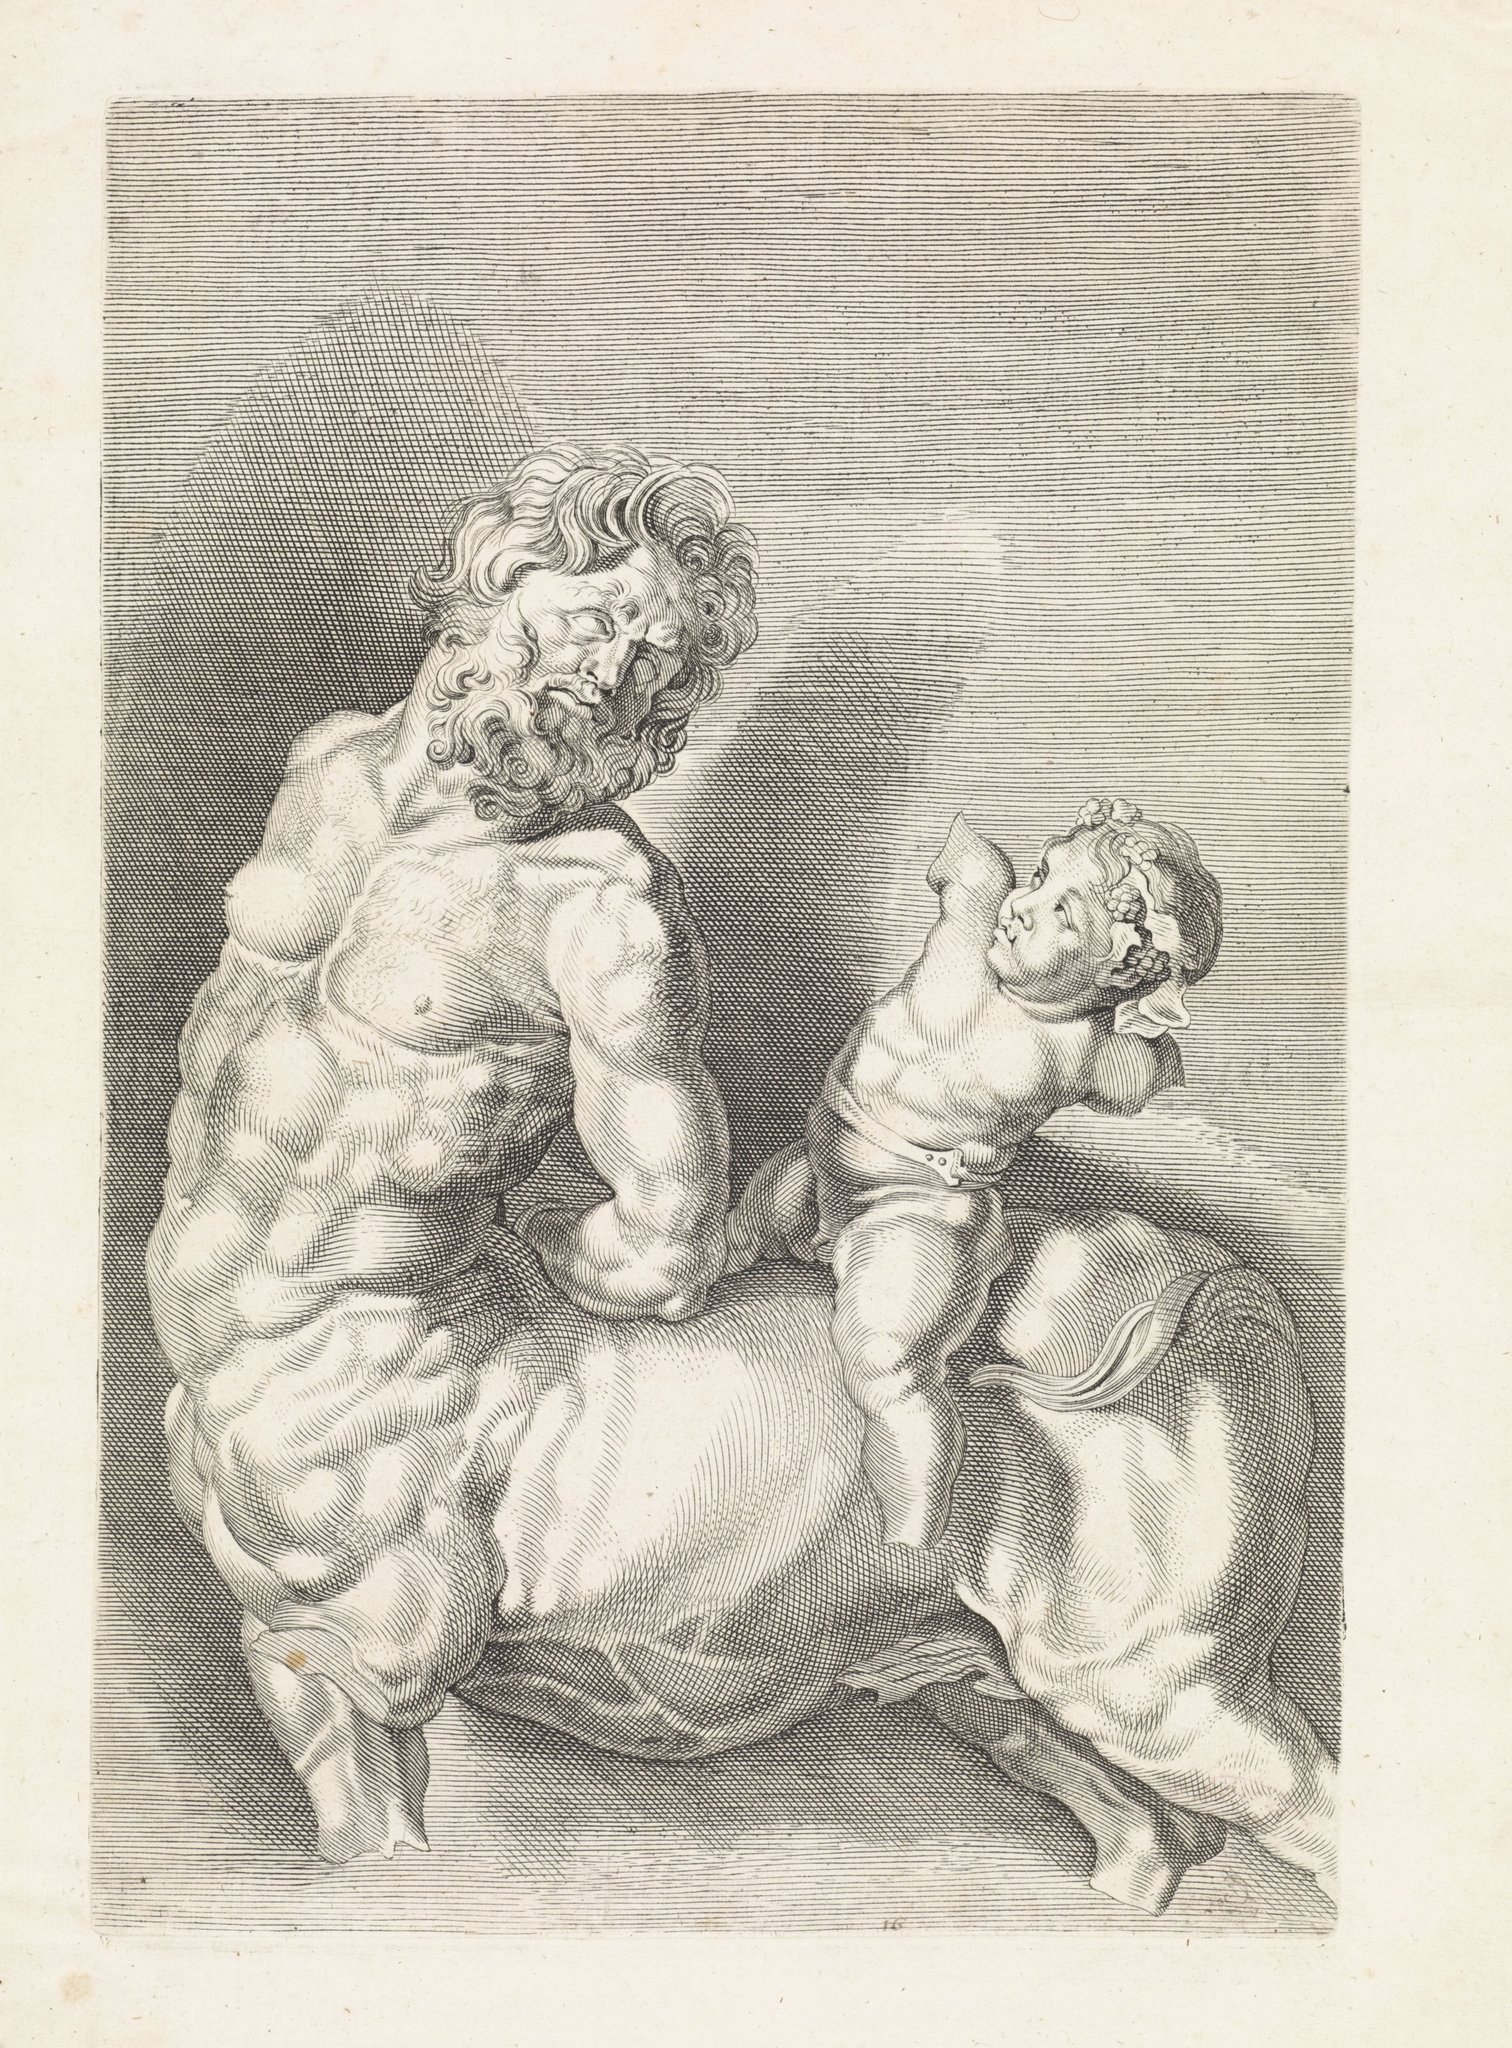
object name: print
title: Het tekenboek van Peter Paul Rubens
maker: paulus pontius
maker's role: draughtsman, print maker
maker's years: 1603-1658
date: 1616-1657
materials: paper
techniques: engraving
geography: antwerp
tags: centaurs, piece of sculpture, reproduction of a piece of sculpture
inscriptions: number: ‘16’, collector's mark: Lugt 240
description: Antiek beeld van een centaur die zich omdraait naar een putto die hem berijdt.